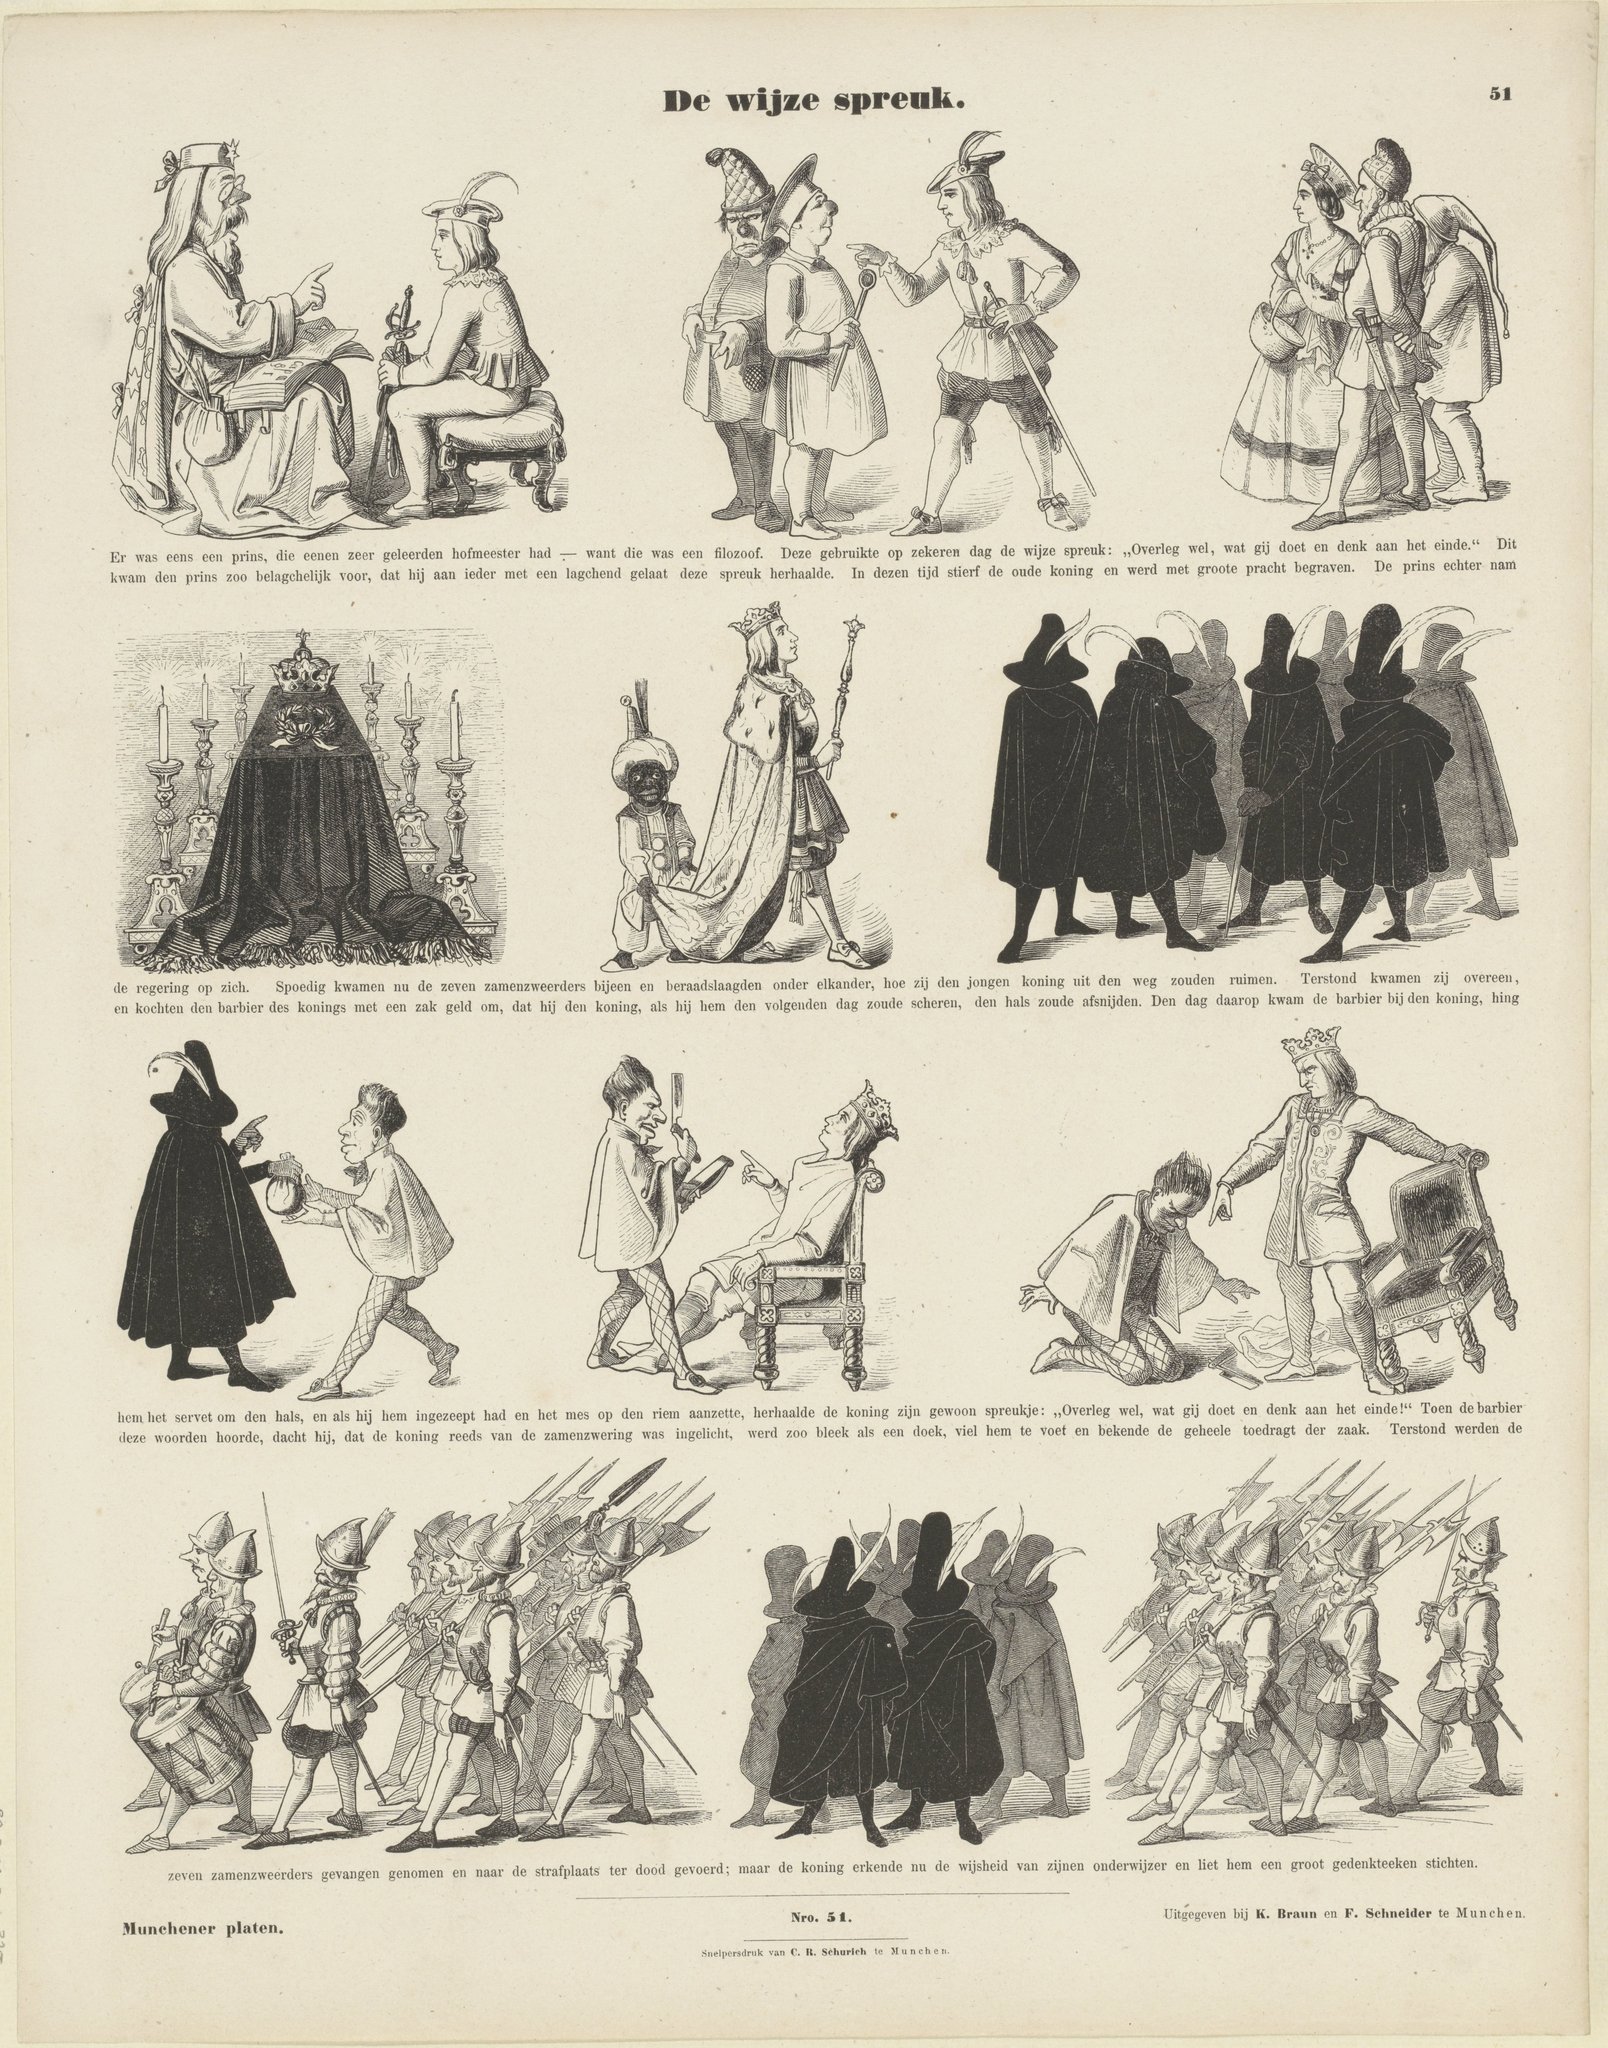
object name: print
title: Munchener platen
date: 1843-1920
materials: paper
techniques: letterpress printing, engraving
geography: munich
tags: bewitching, cursing, casting spells, prince, ruler, sovereign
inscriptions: collector's mark: Lugt 2760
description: Blad met vier horizontale rijen met in totaal 12 voorstellingen over hoe een koning ontkomt aan een dodelijke samenzwering door de spreuk van een filosoof. Onder elke rij afbeeldingen een onderschrift. Genummerd midden onder: Nro. 51. Genummerd rechtsboven: 51.